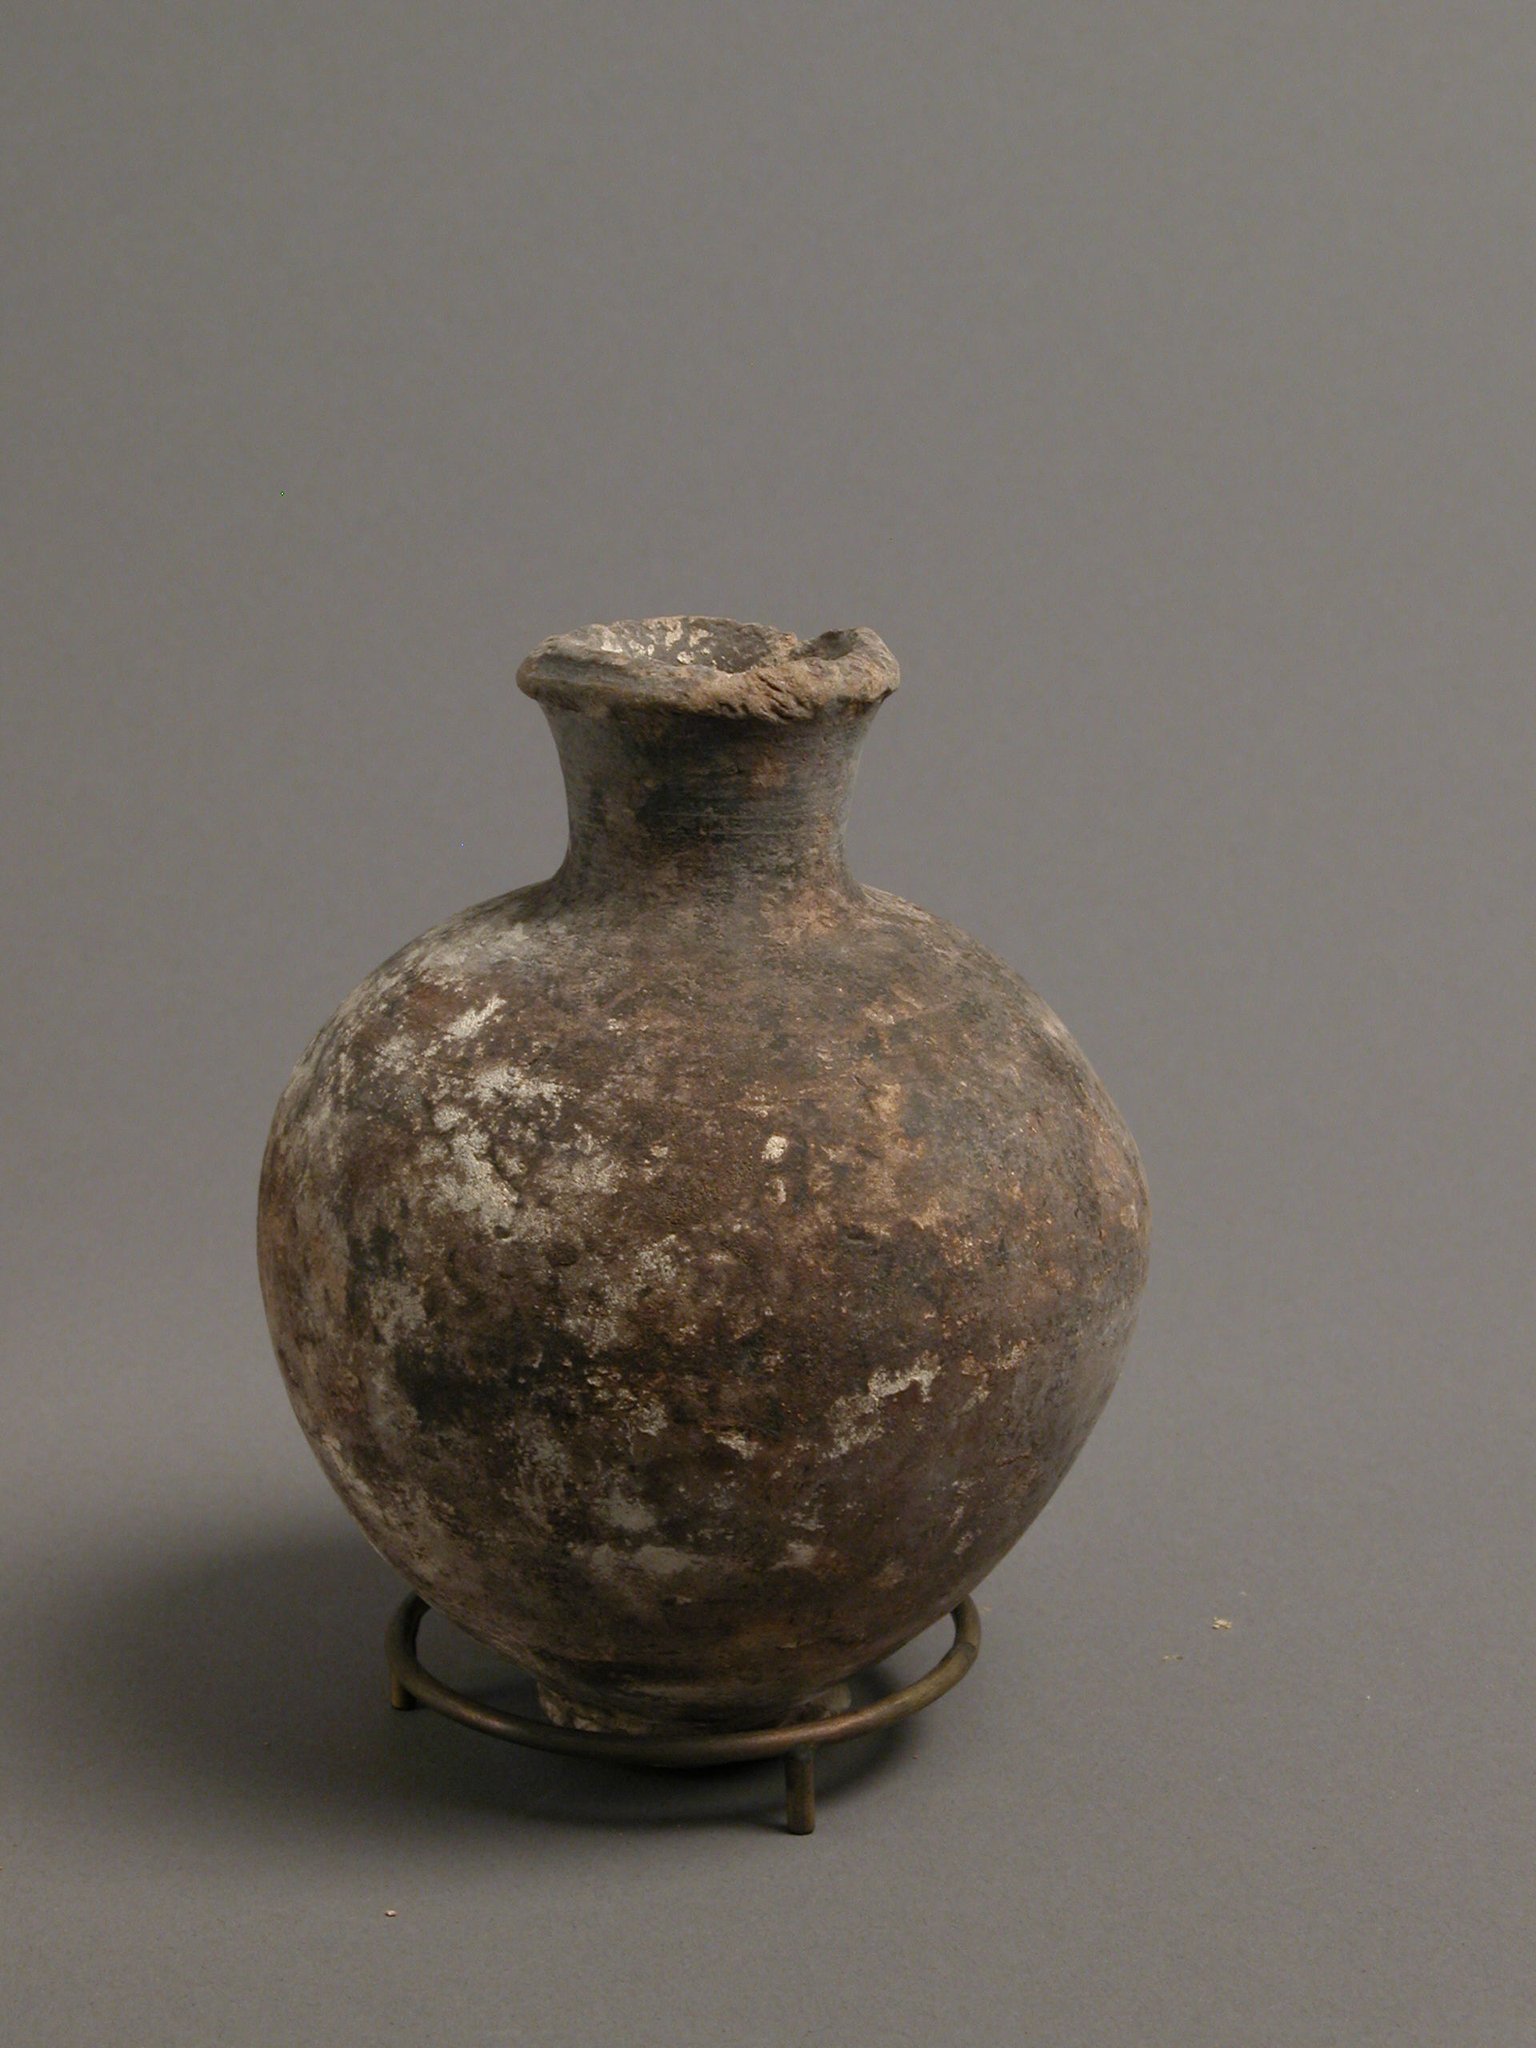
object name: vase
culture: coptic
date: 301-700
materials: earthenware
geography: egypt